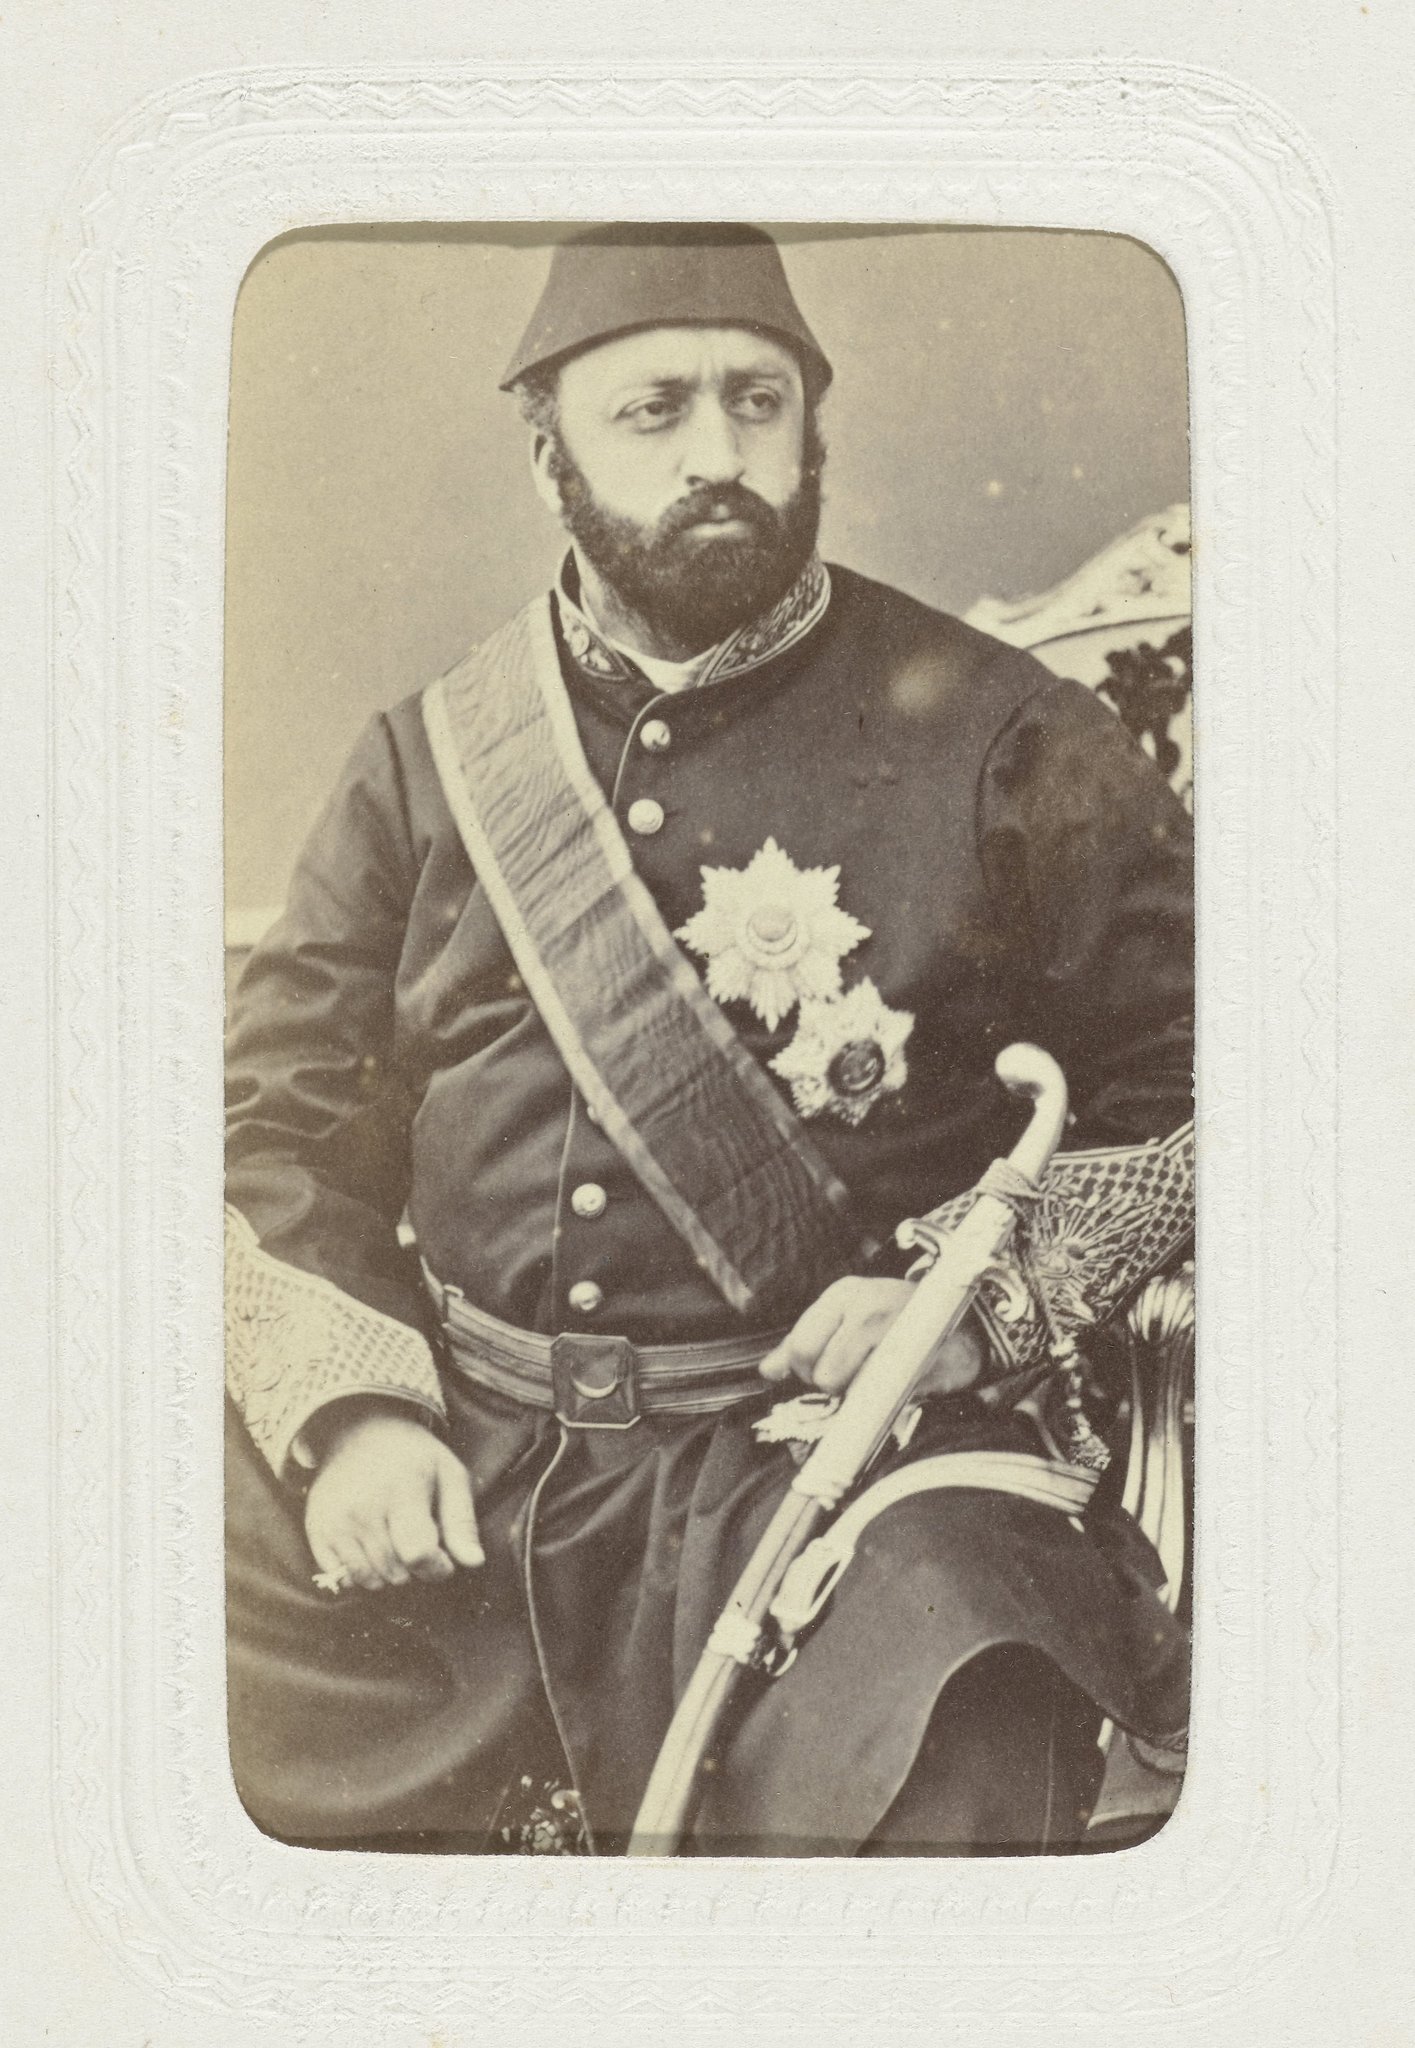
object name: carte de visite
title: Studioportret van Abdülaziz, 32e sultan van het Ottomaanse Rijk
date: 1863-1866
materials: cardboard, paper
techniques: albumen print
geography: istanbul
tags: historical persons, emperor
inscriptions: stamp: ‘Abdullah freres Istanbul’